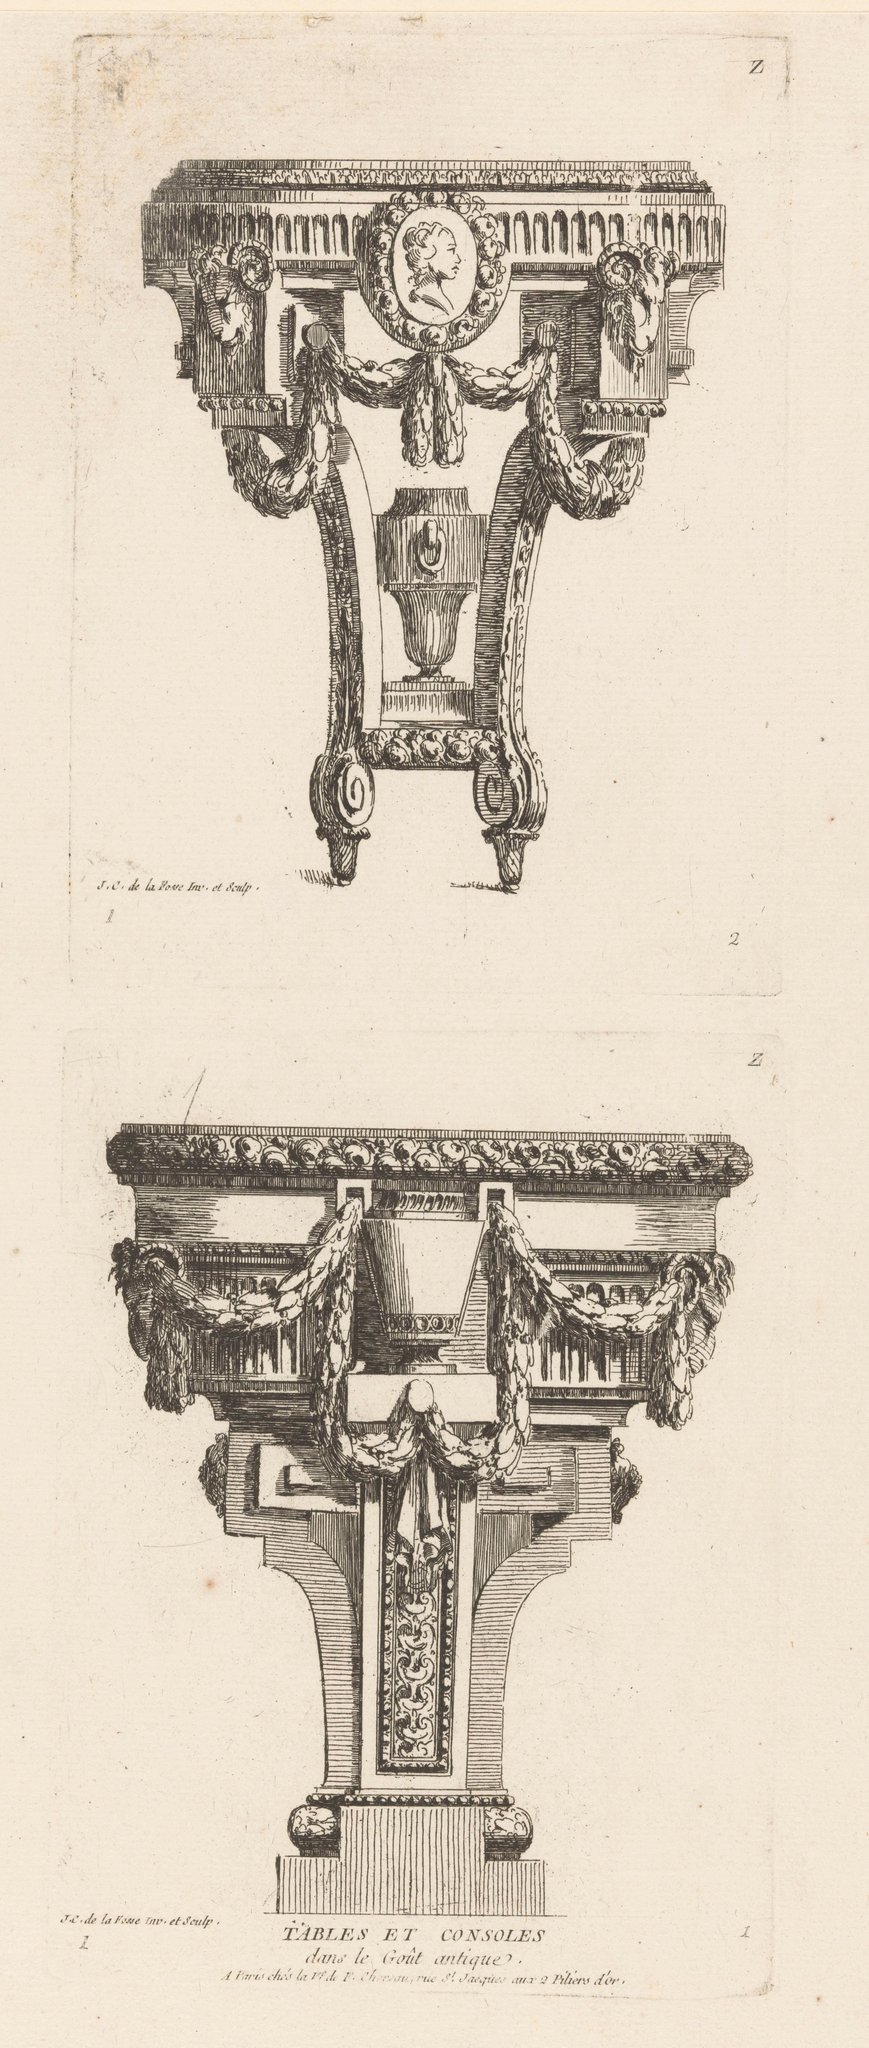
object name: ornament print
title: IIe Volume De l'Oeuvre de J. Ch. Delafosse (...)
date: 1771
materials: paper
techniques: etching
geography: paris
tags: ornament ~ medallion, vase ~ ornament, table, ornament ~ festoon, garland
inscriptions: collector's mark: Lugt 2760, collector's mark: Lugt 2228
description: Twee tafels op een blad. Boven een tafel met een medaillon met vrouwenportret en profil, twee ramskoppen, een vaas en guirlandes. Onder een tafel met een vaas, ramskoppen en guirlandes. Links onder 1 genummerd.